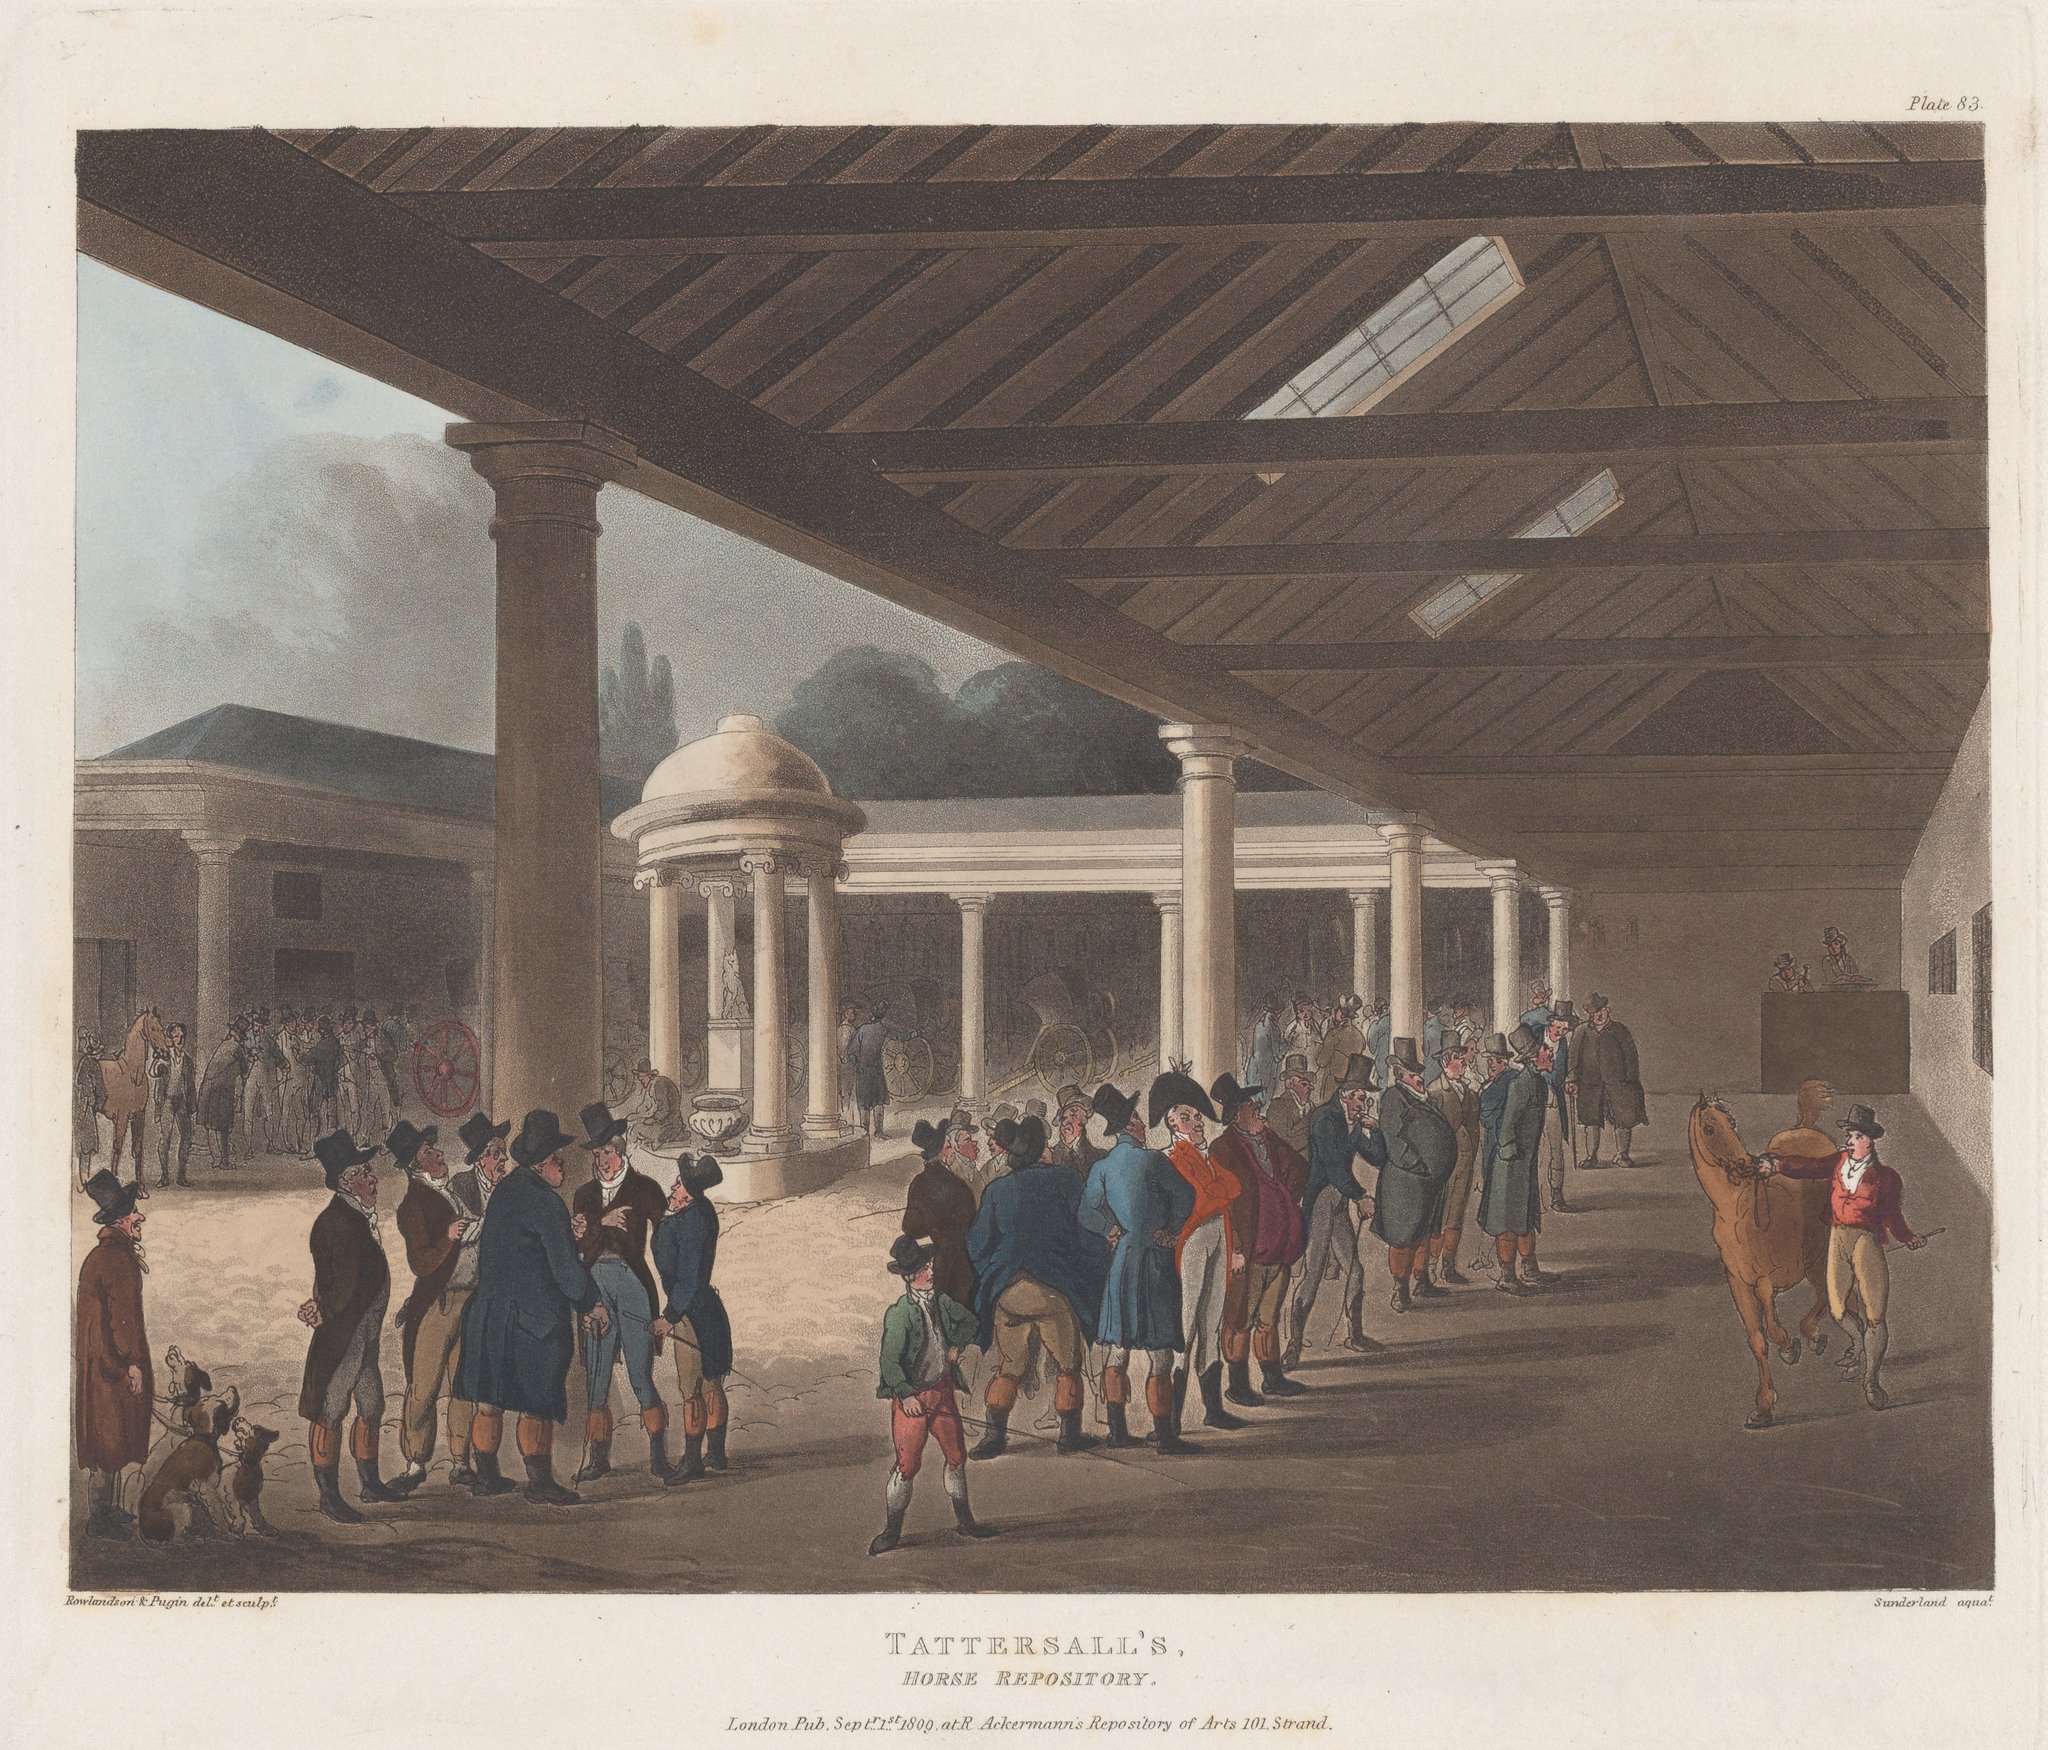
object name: print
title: Tattersall's, Horse Repository, Hyde Park Corner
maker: thomas rowlandson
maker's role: artist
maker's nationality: british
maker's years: 1757-1827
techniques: aquatint, etching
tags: men,horses,london